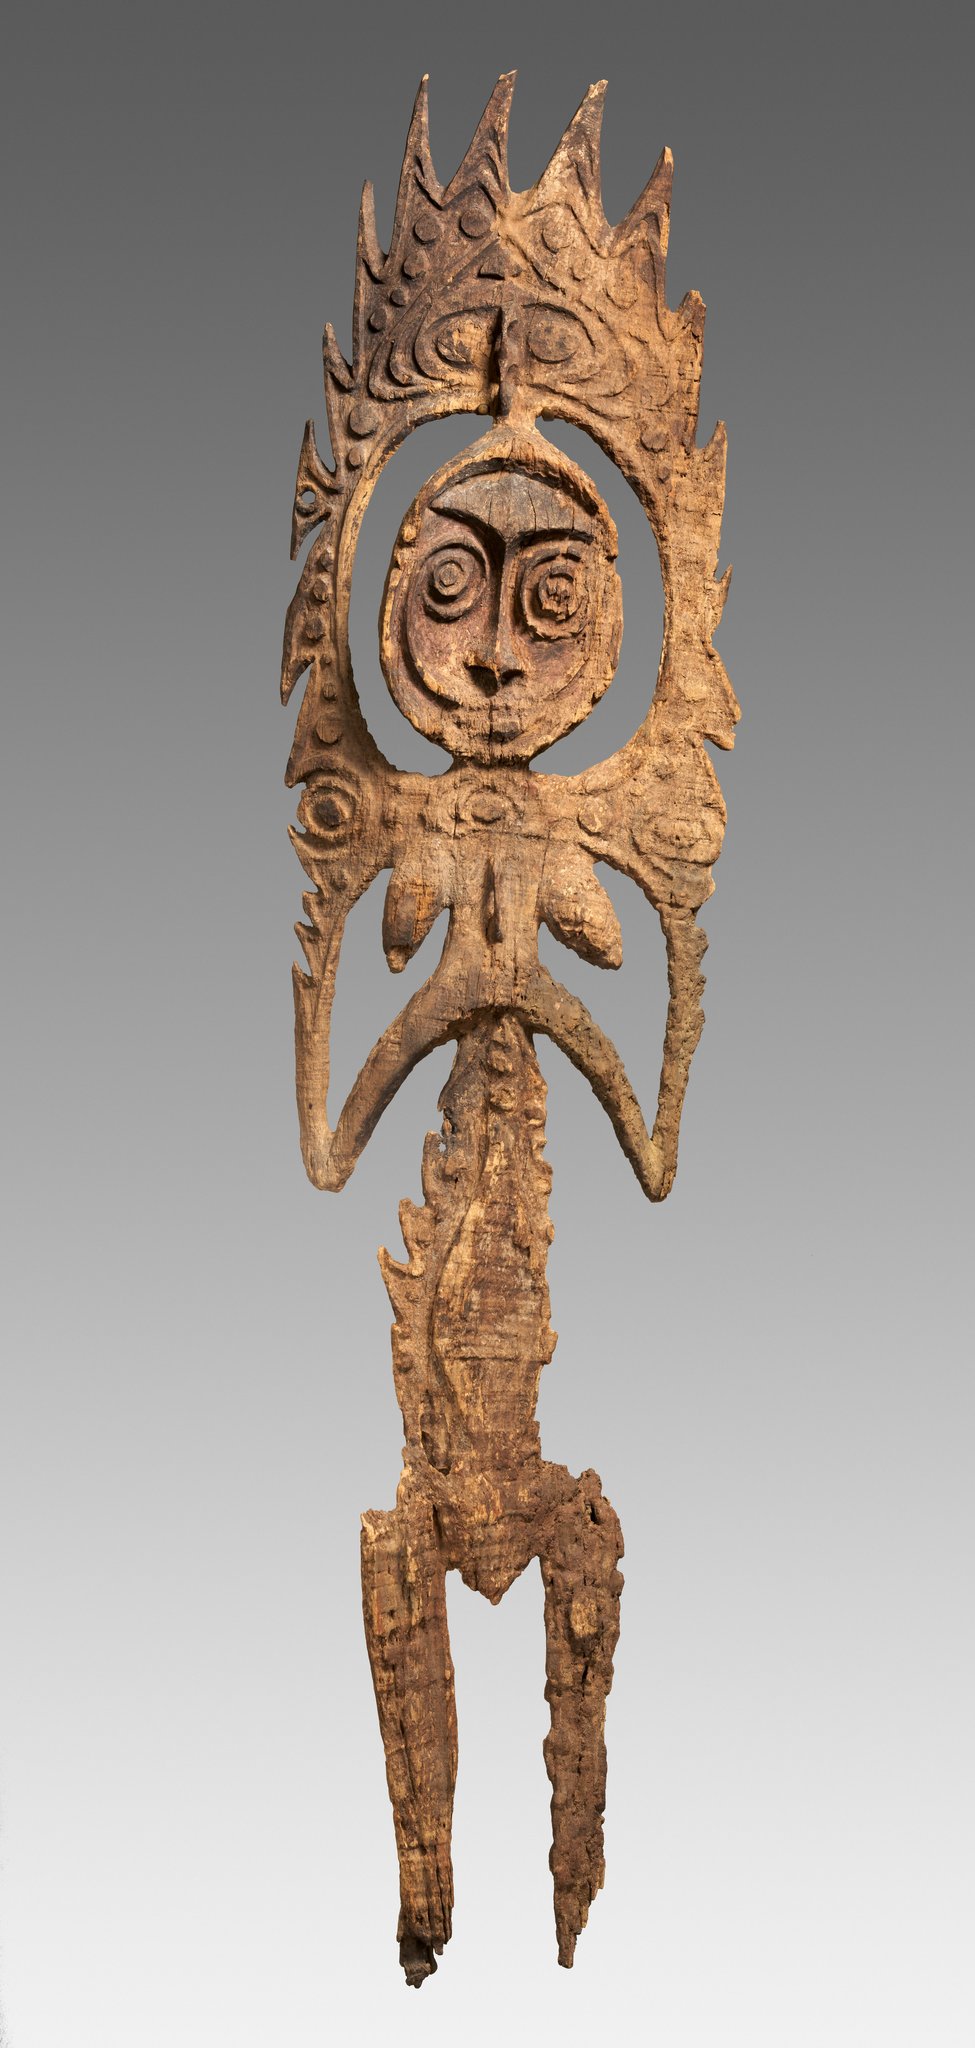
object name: female figure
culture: inyai-ewa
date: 1501-1900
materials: wood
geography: papua new guinea